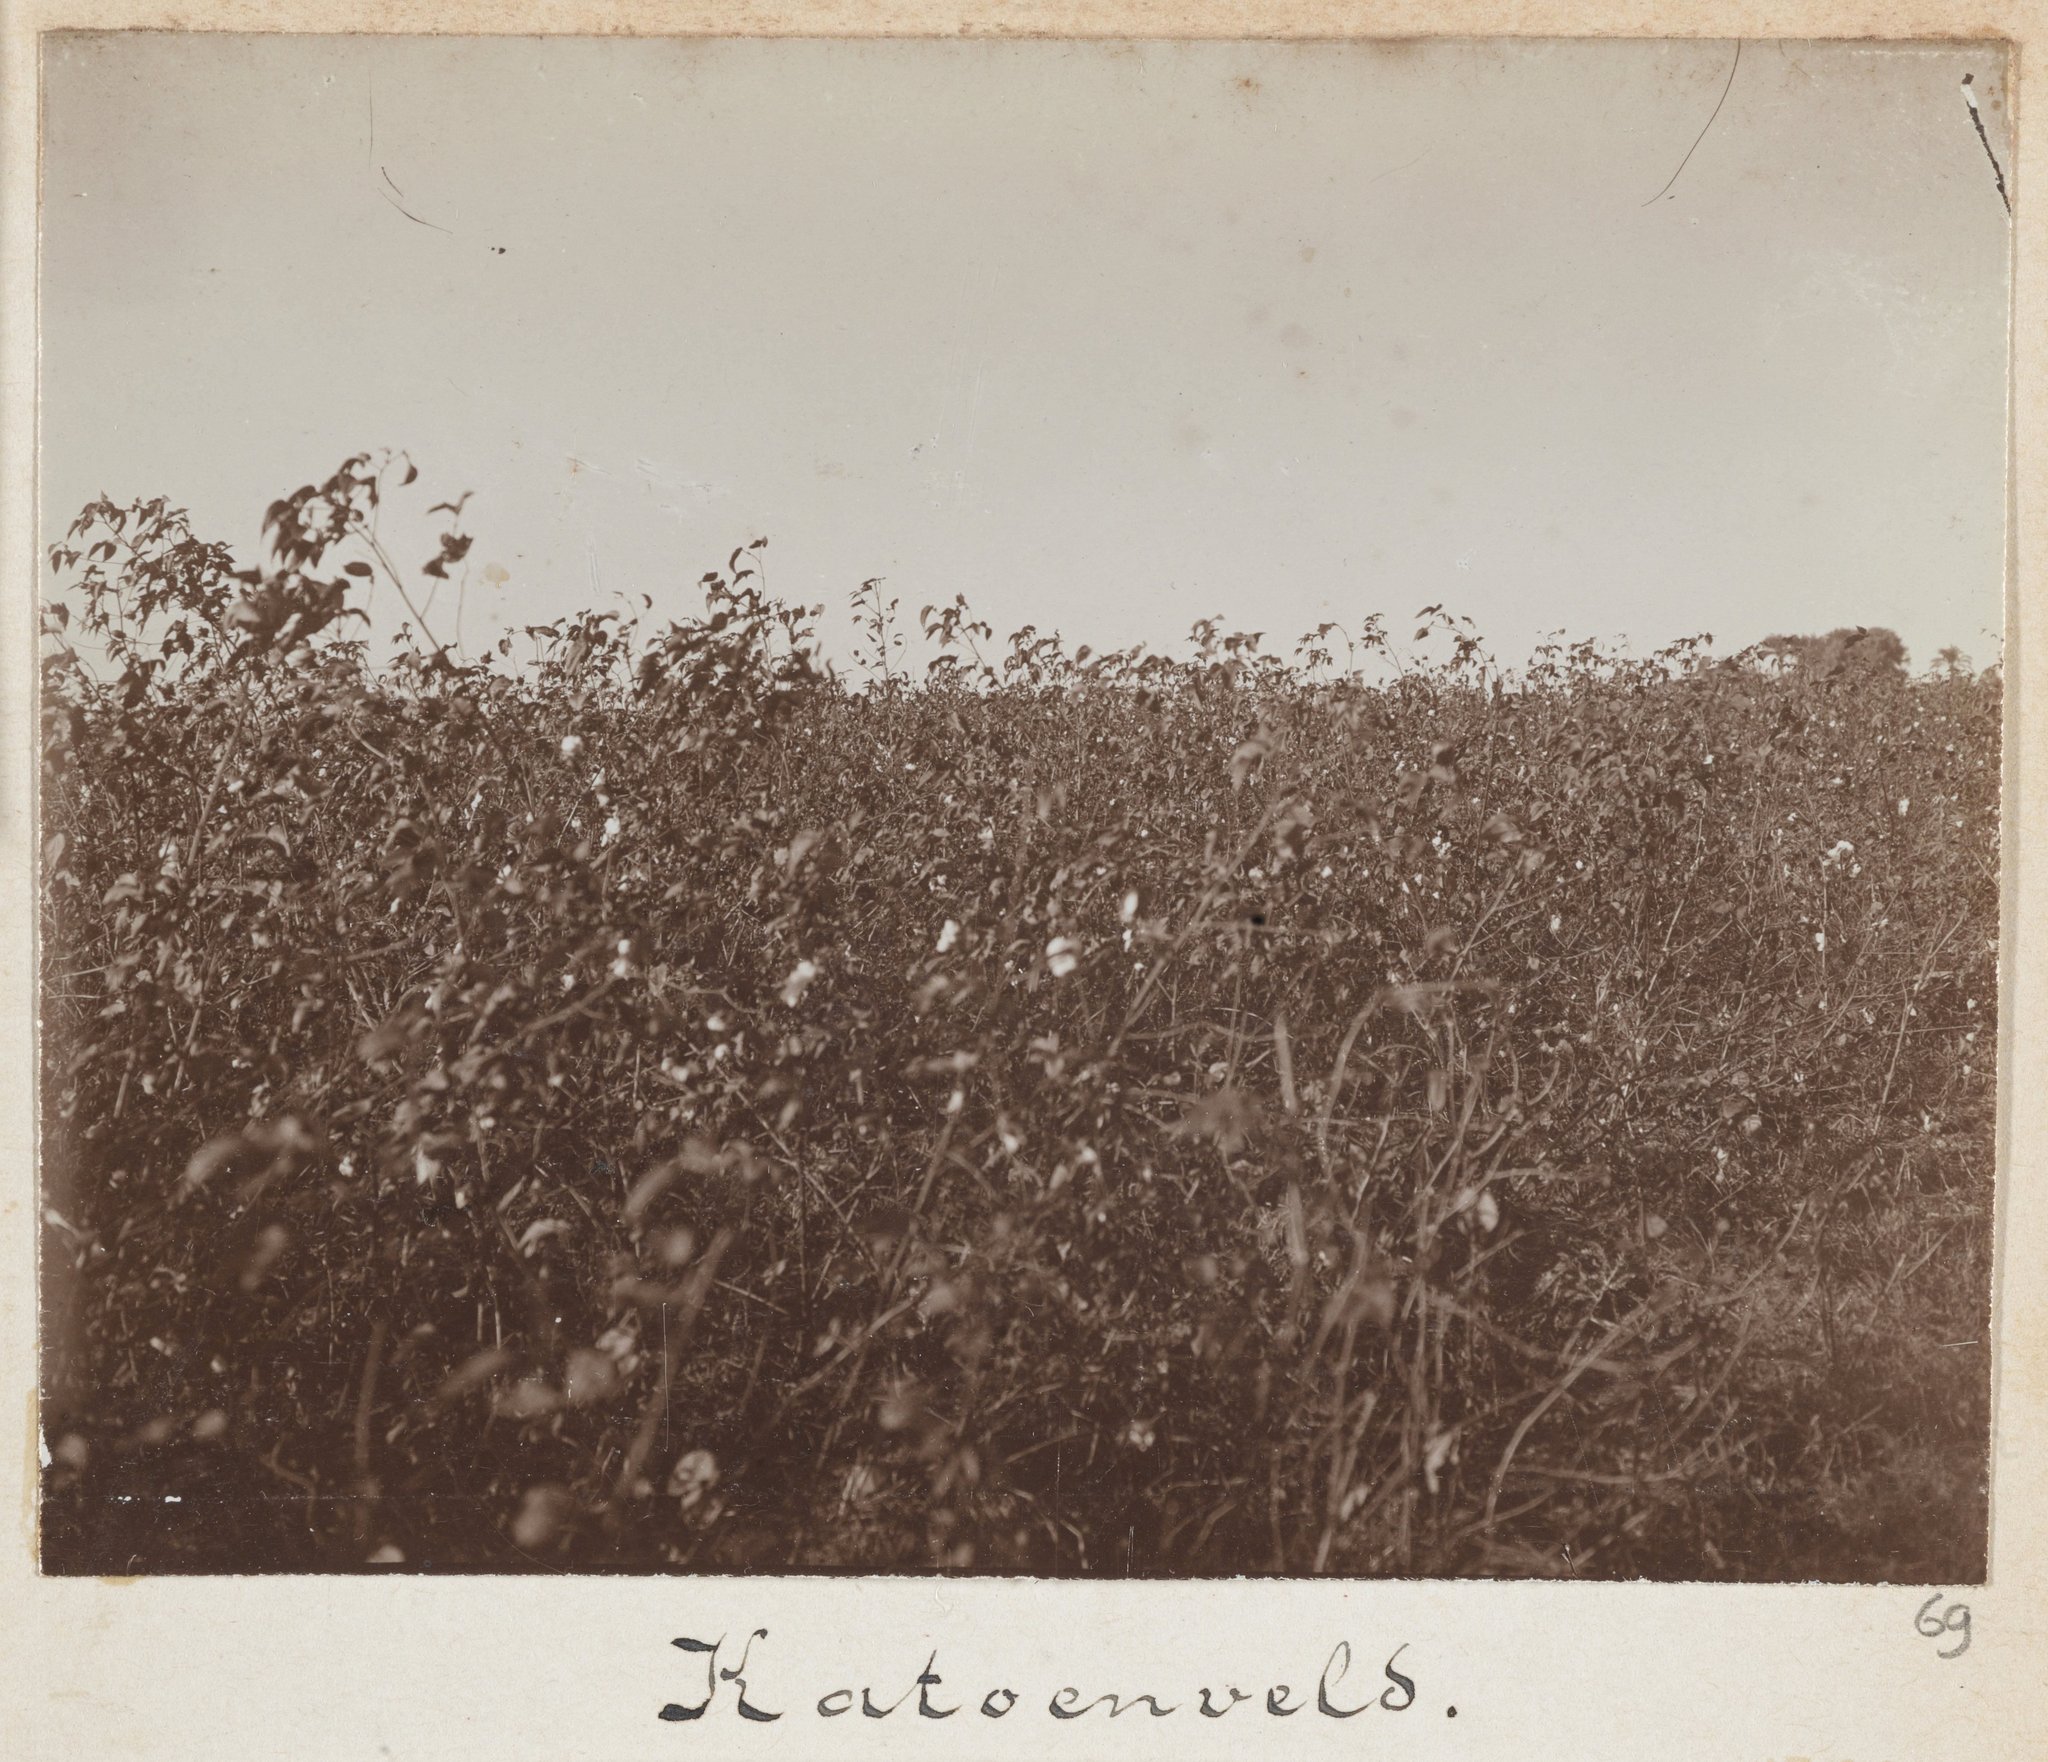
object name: photograph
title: Katoenveld bij Caïro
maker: johannes lodewijk heldring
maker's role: fotograaf, predikant, schrijver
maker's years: 1852-1923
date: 1898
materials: paper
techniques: collodion silver print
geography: cairo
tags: field filled with a crop, cotton (material ~ textile industry)